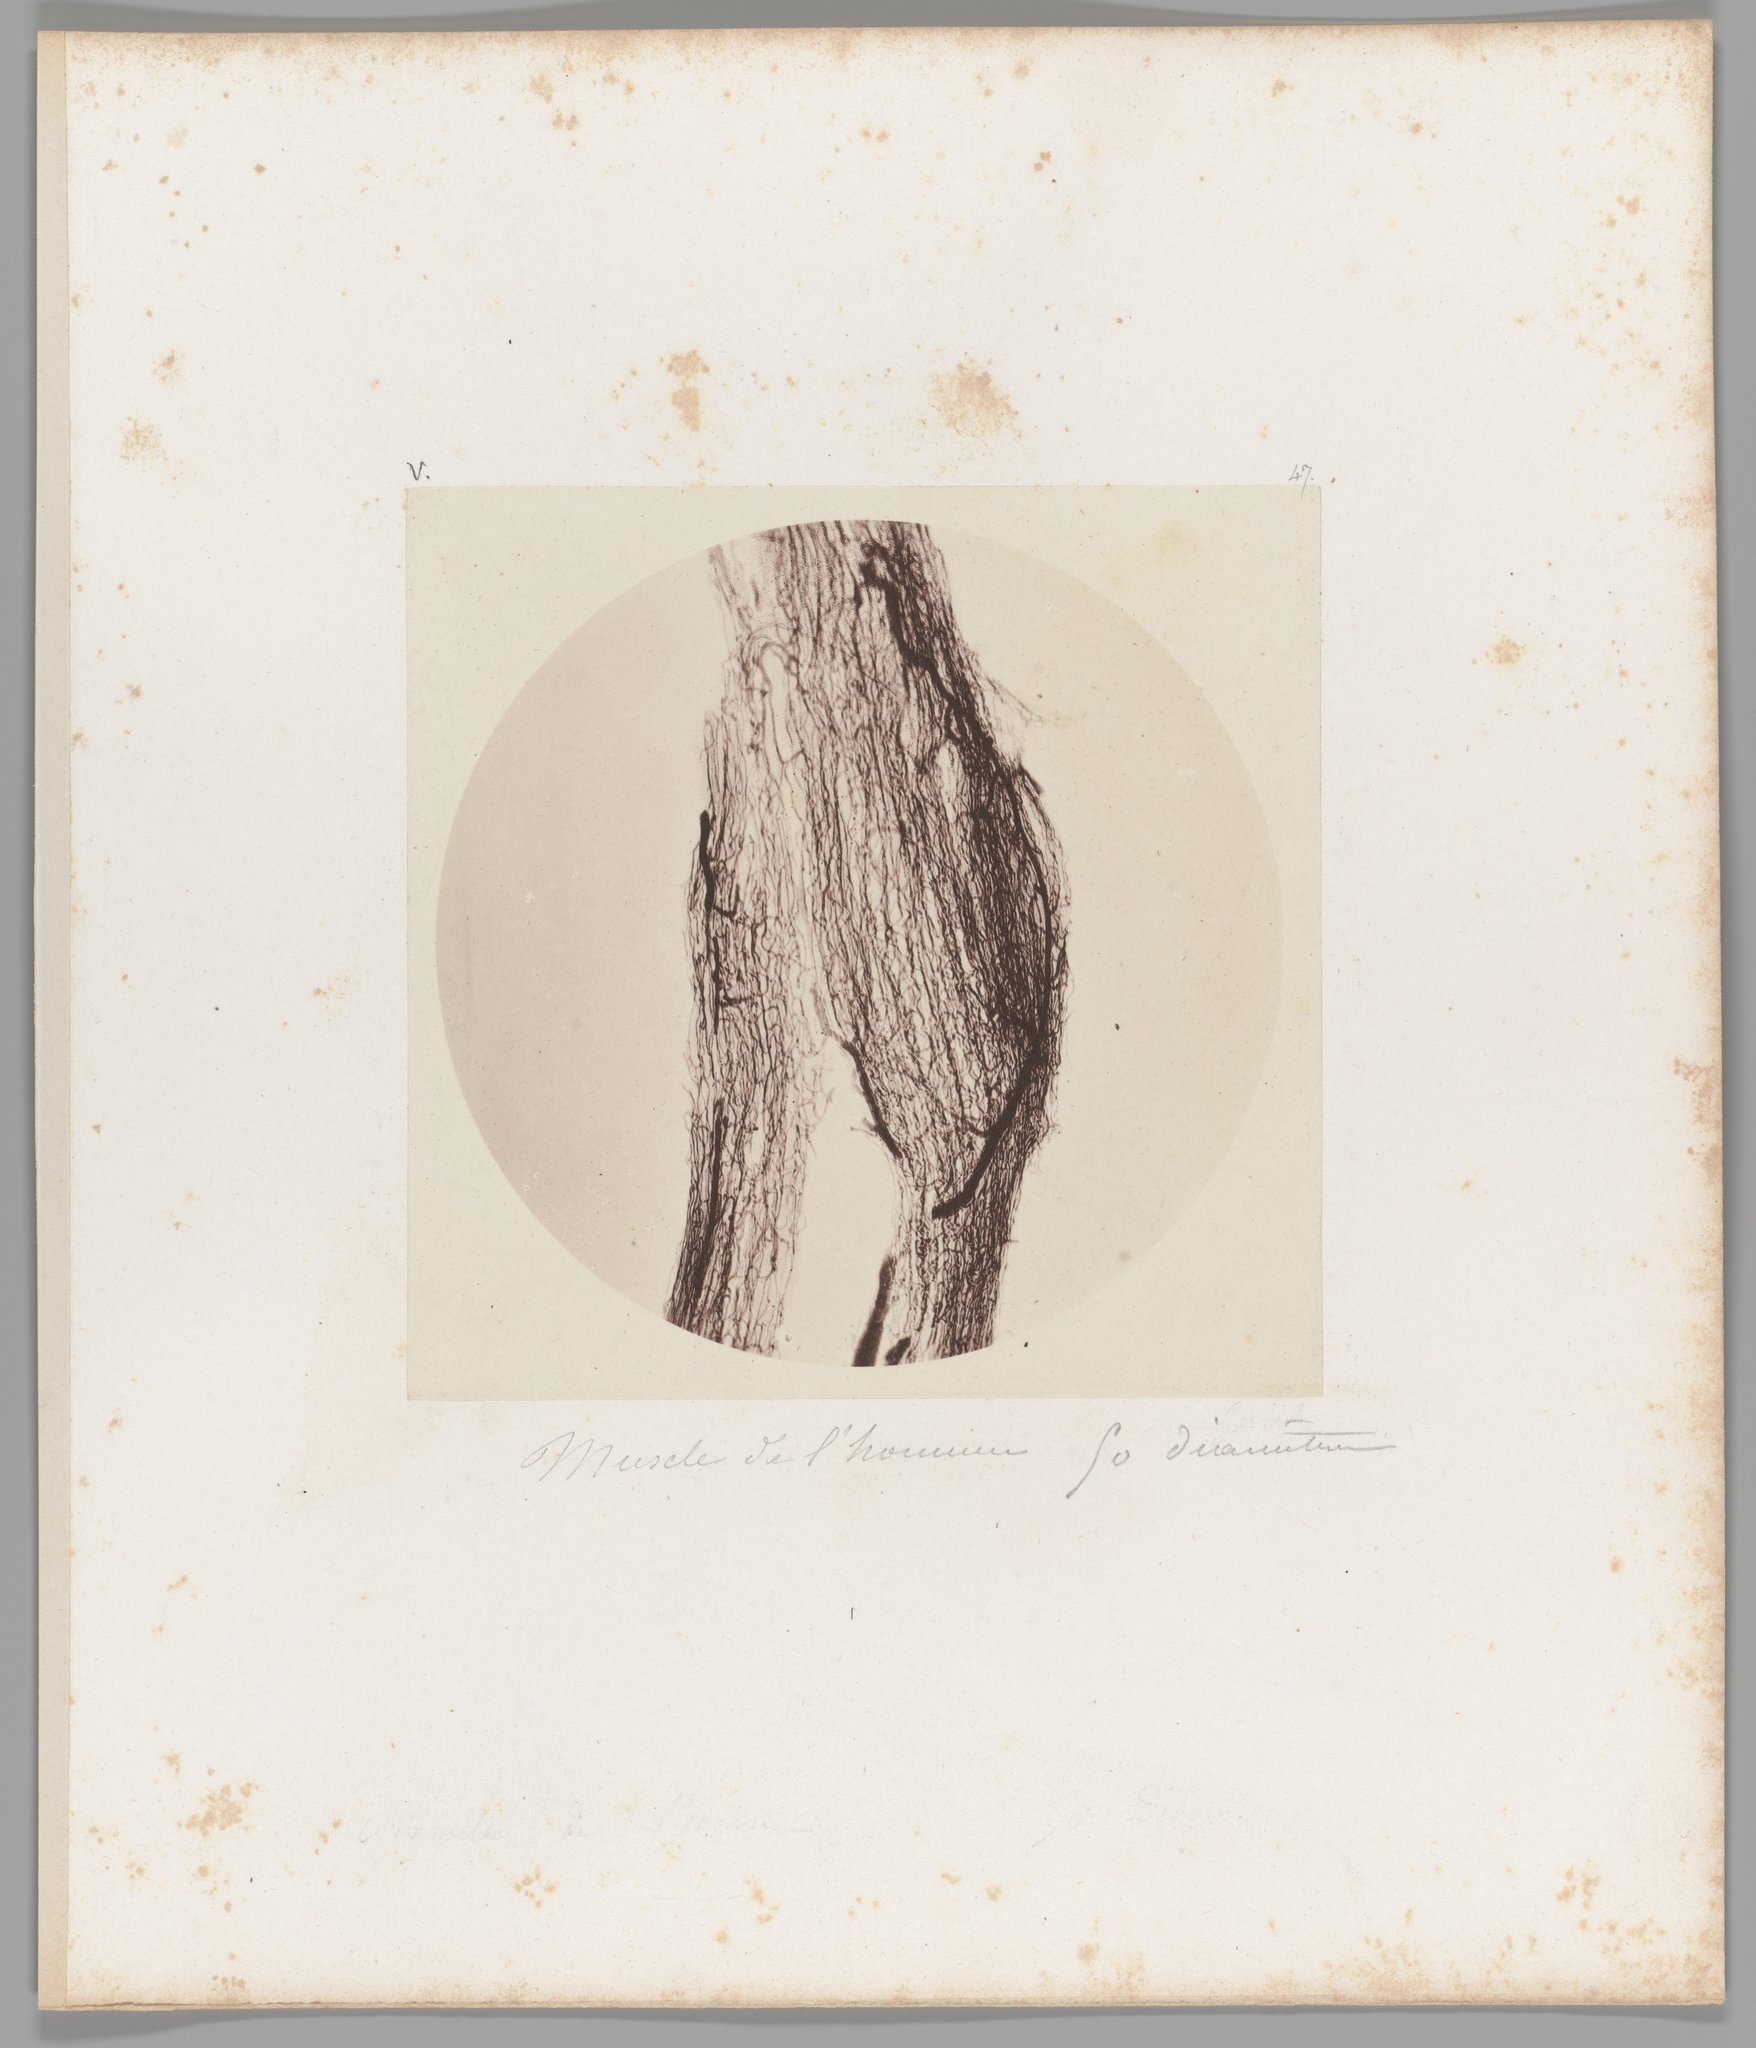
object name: photograph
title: [Untitled]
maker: auguste-adolphe bertsch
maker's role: artist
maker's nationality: french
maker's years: 1813-1871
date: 1853-1857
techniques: salted paper print